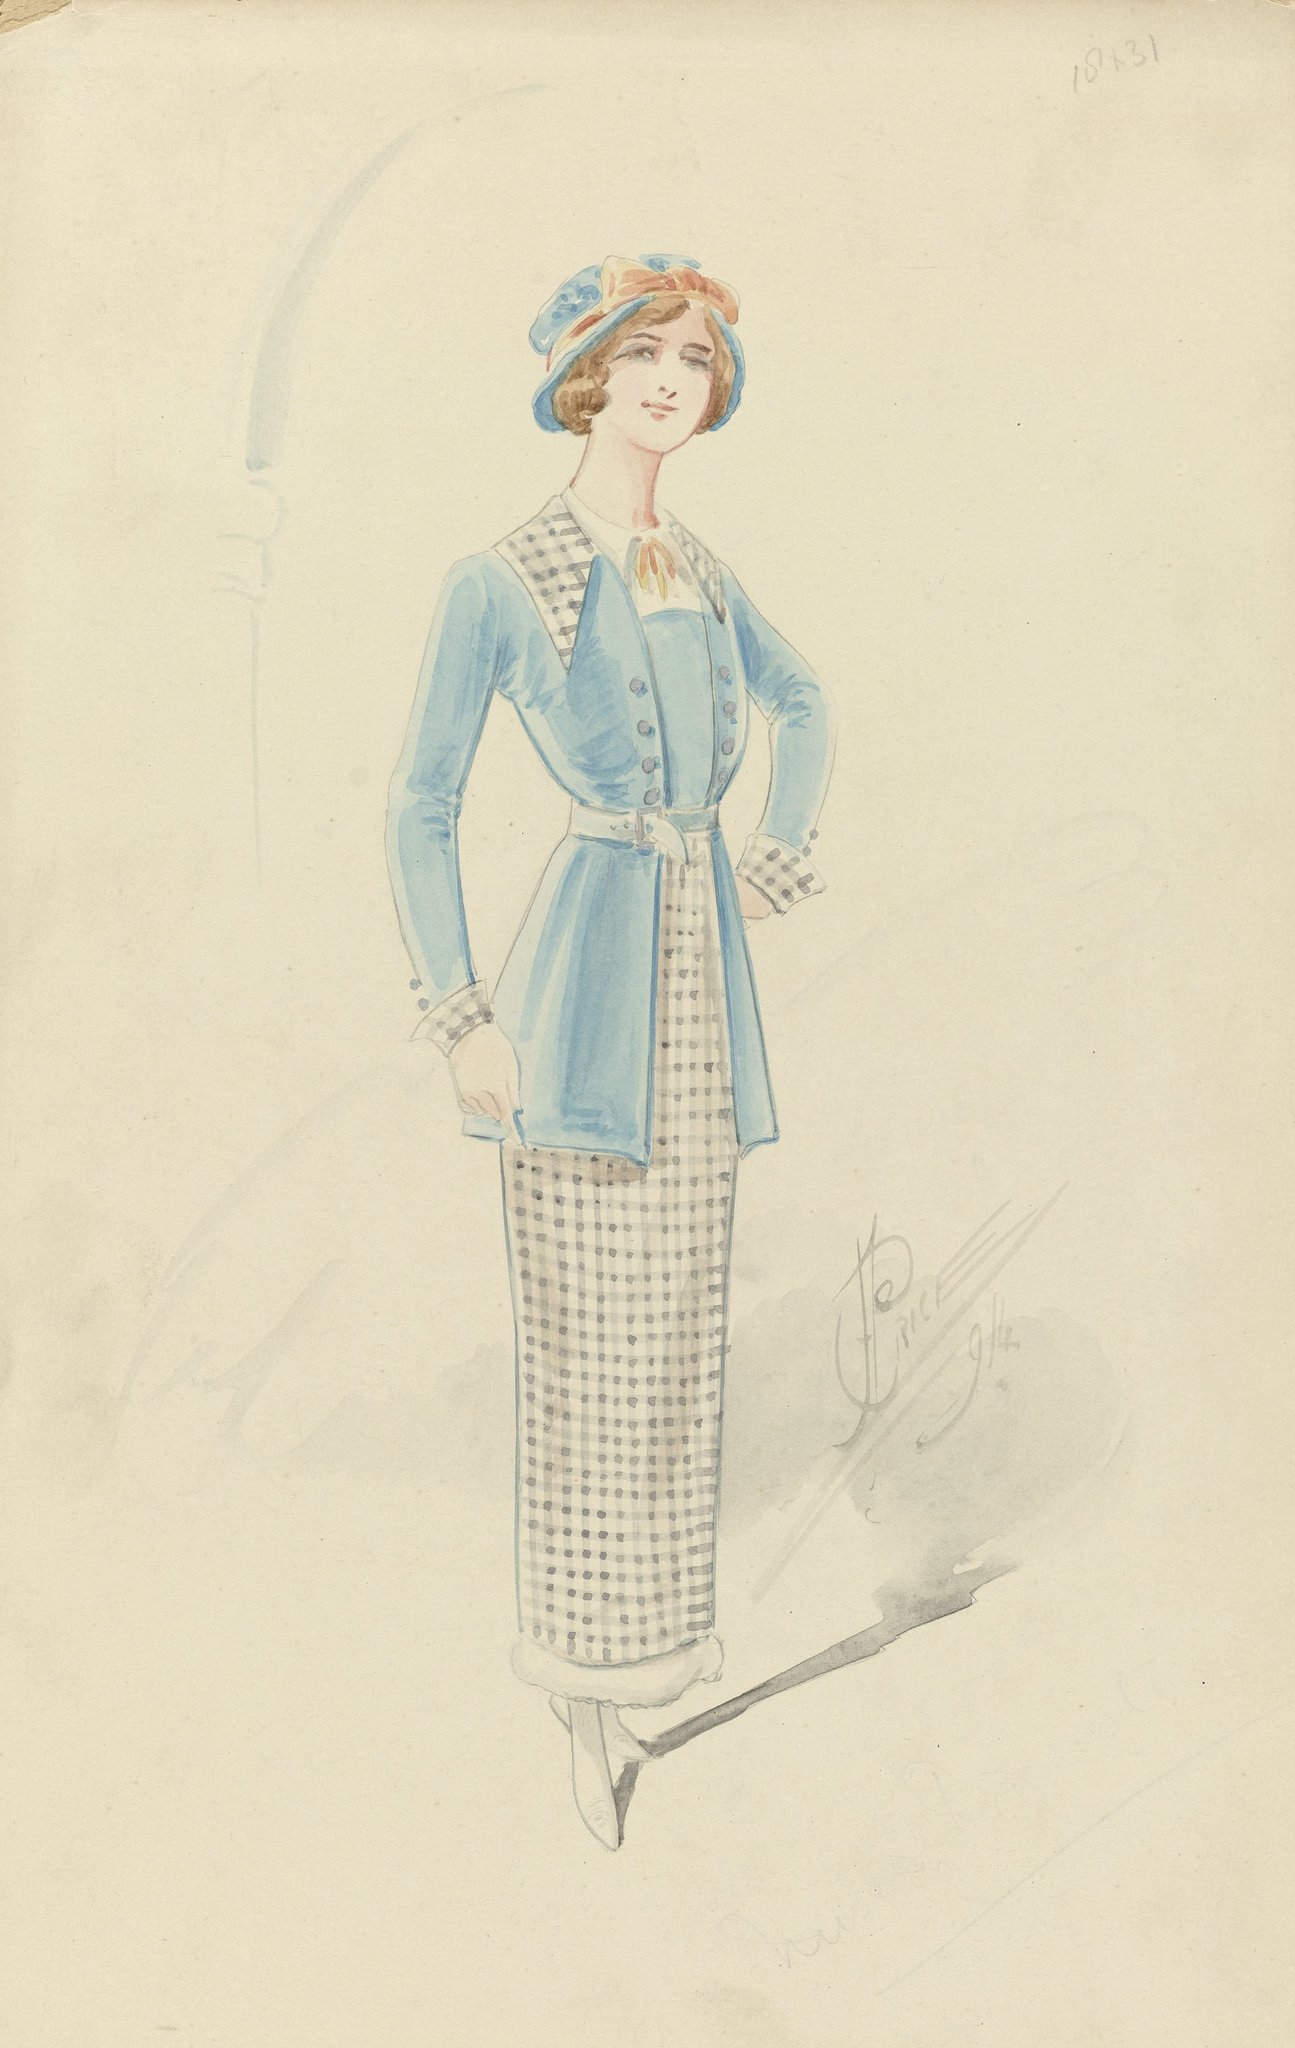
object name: drawing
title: Jonge vrouw in zwart-wit geblokt ensemble, 1914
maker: price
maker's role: artist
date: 1914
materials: paper, pencil, watercolor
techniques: brush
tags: ensembles of pieces of clothing (two piece suit) (+ women's clothes), fashion plates, head-gear: hat (+ women's clothes)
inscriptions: date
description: Het ensemble bestaat uit een japon met lichtblauw lijfje en een zwart-wit geblokte strakke rok tot op de enkels, aan de onderkant afgezet met een rand van bont. Hierover een kort lichtblauw jasje met kraag en manchetten in geblokte stof. Ceintuur. Hoedje in bijpassende kleur blauw, met lint om de bol.